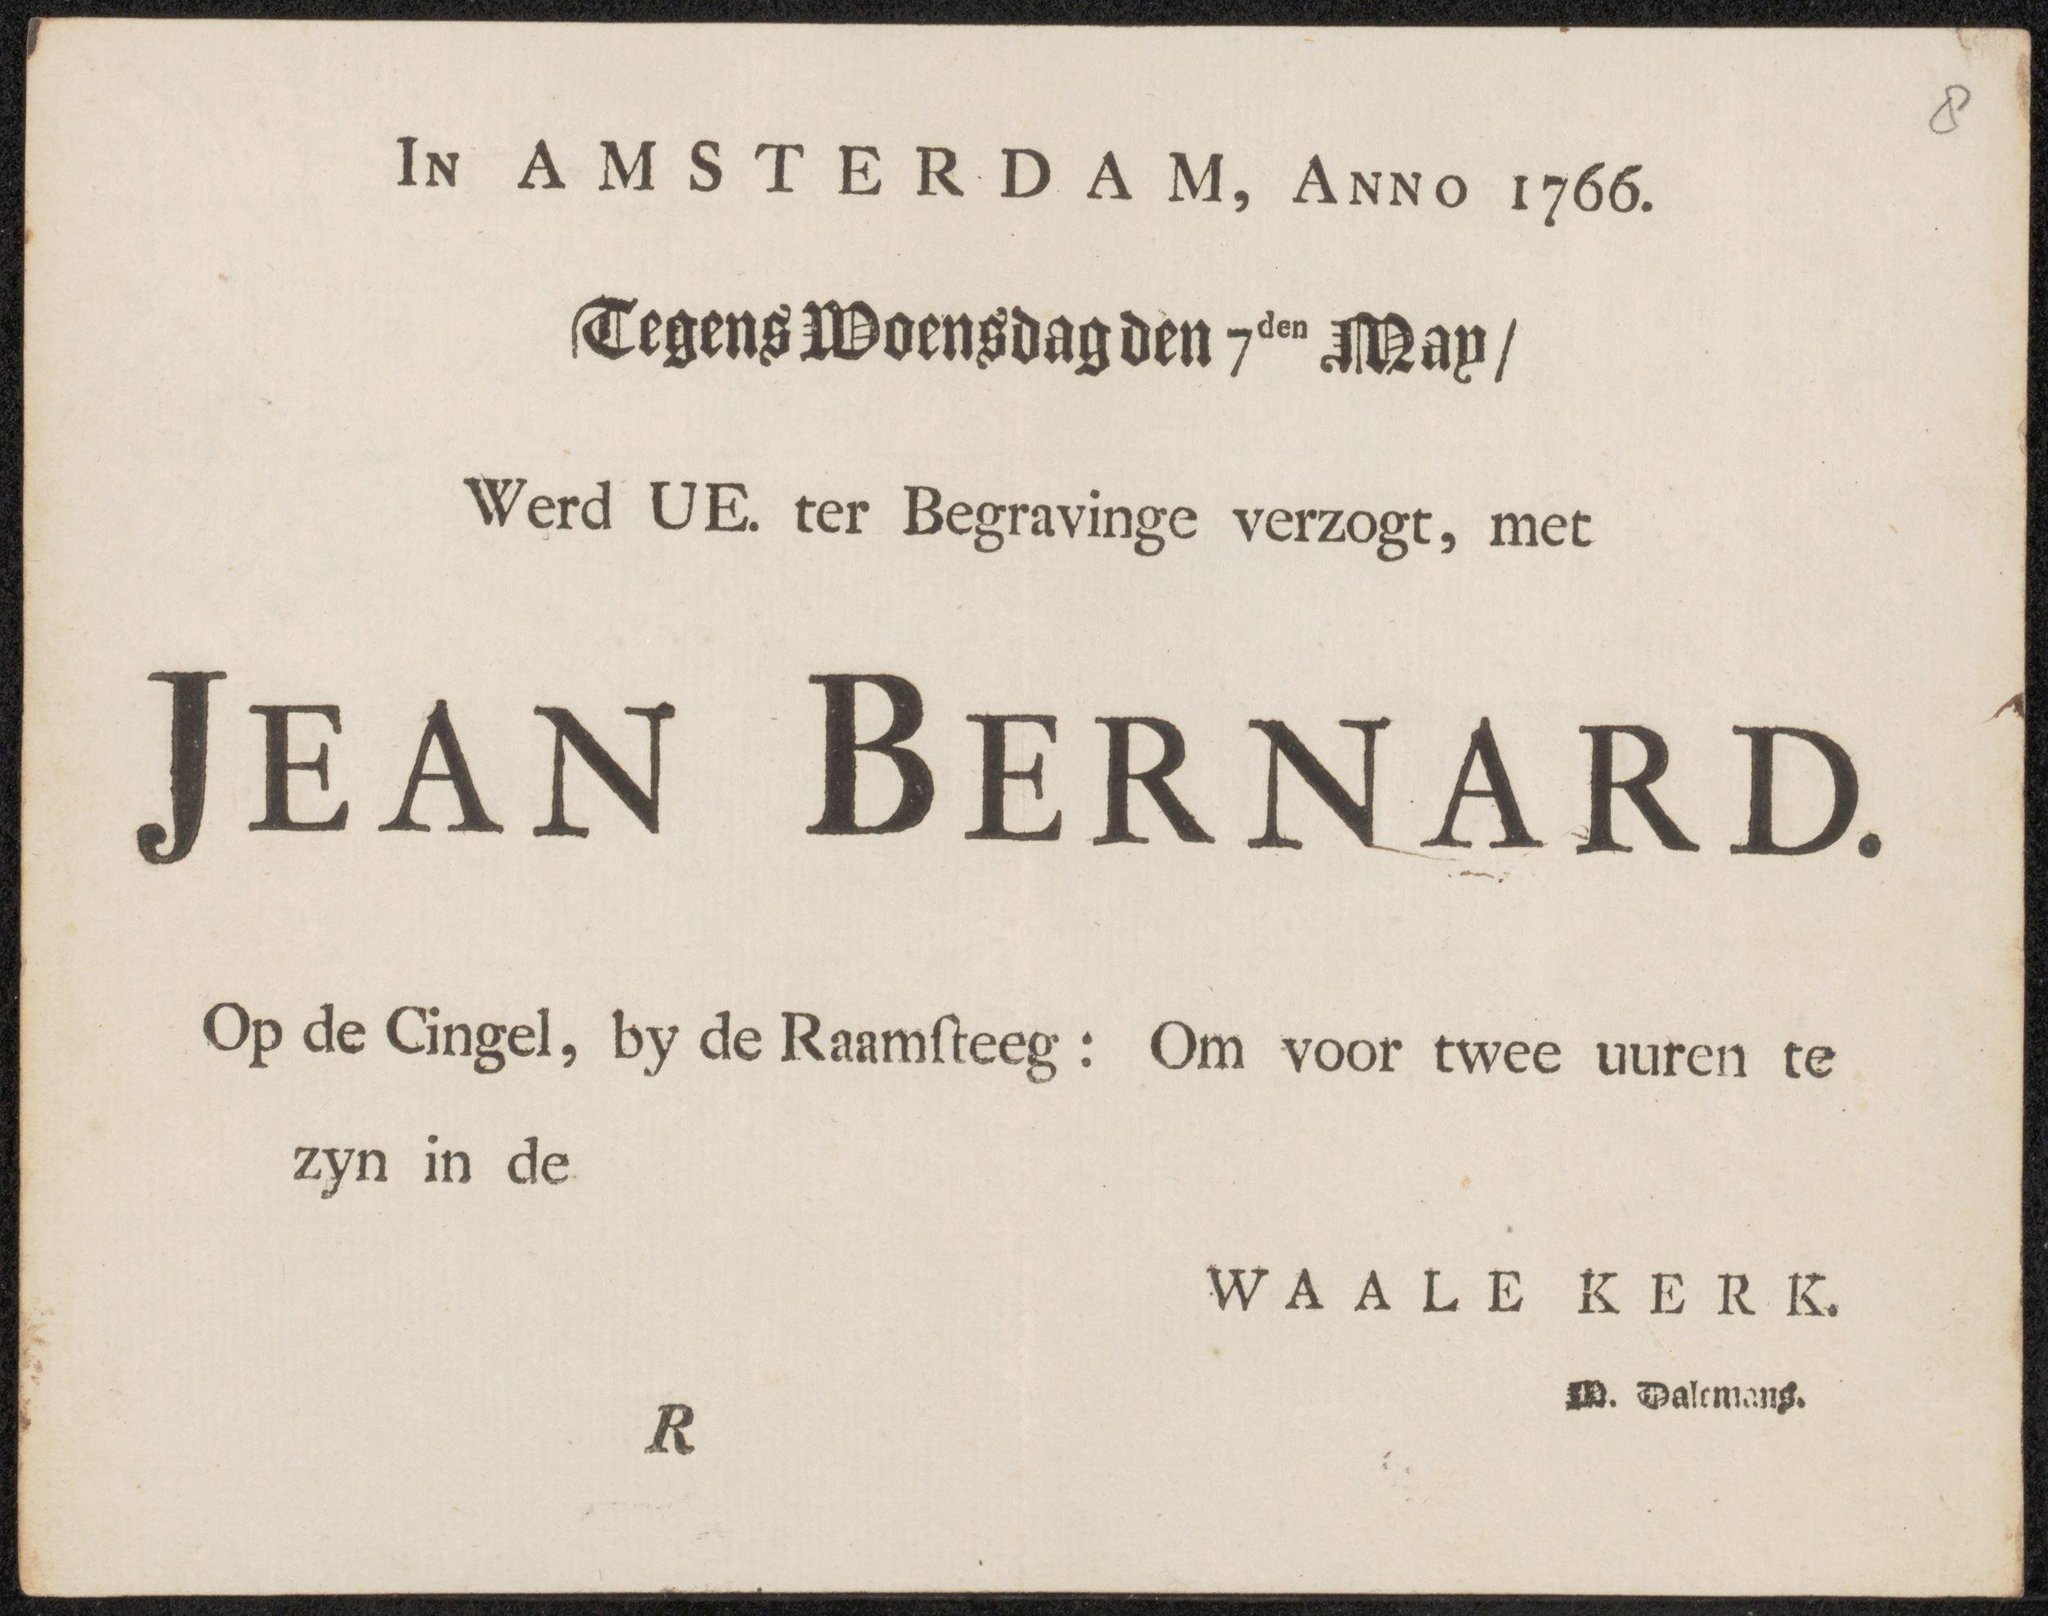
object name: invitation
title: Uitnodiging voor de begrafenis van Jean Bernard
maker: Anonymous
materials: paper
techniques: printing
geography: amsterdam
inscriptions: collector's mark: Lugt 2233, watermark